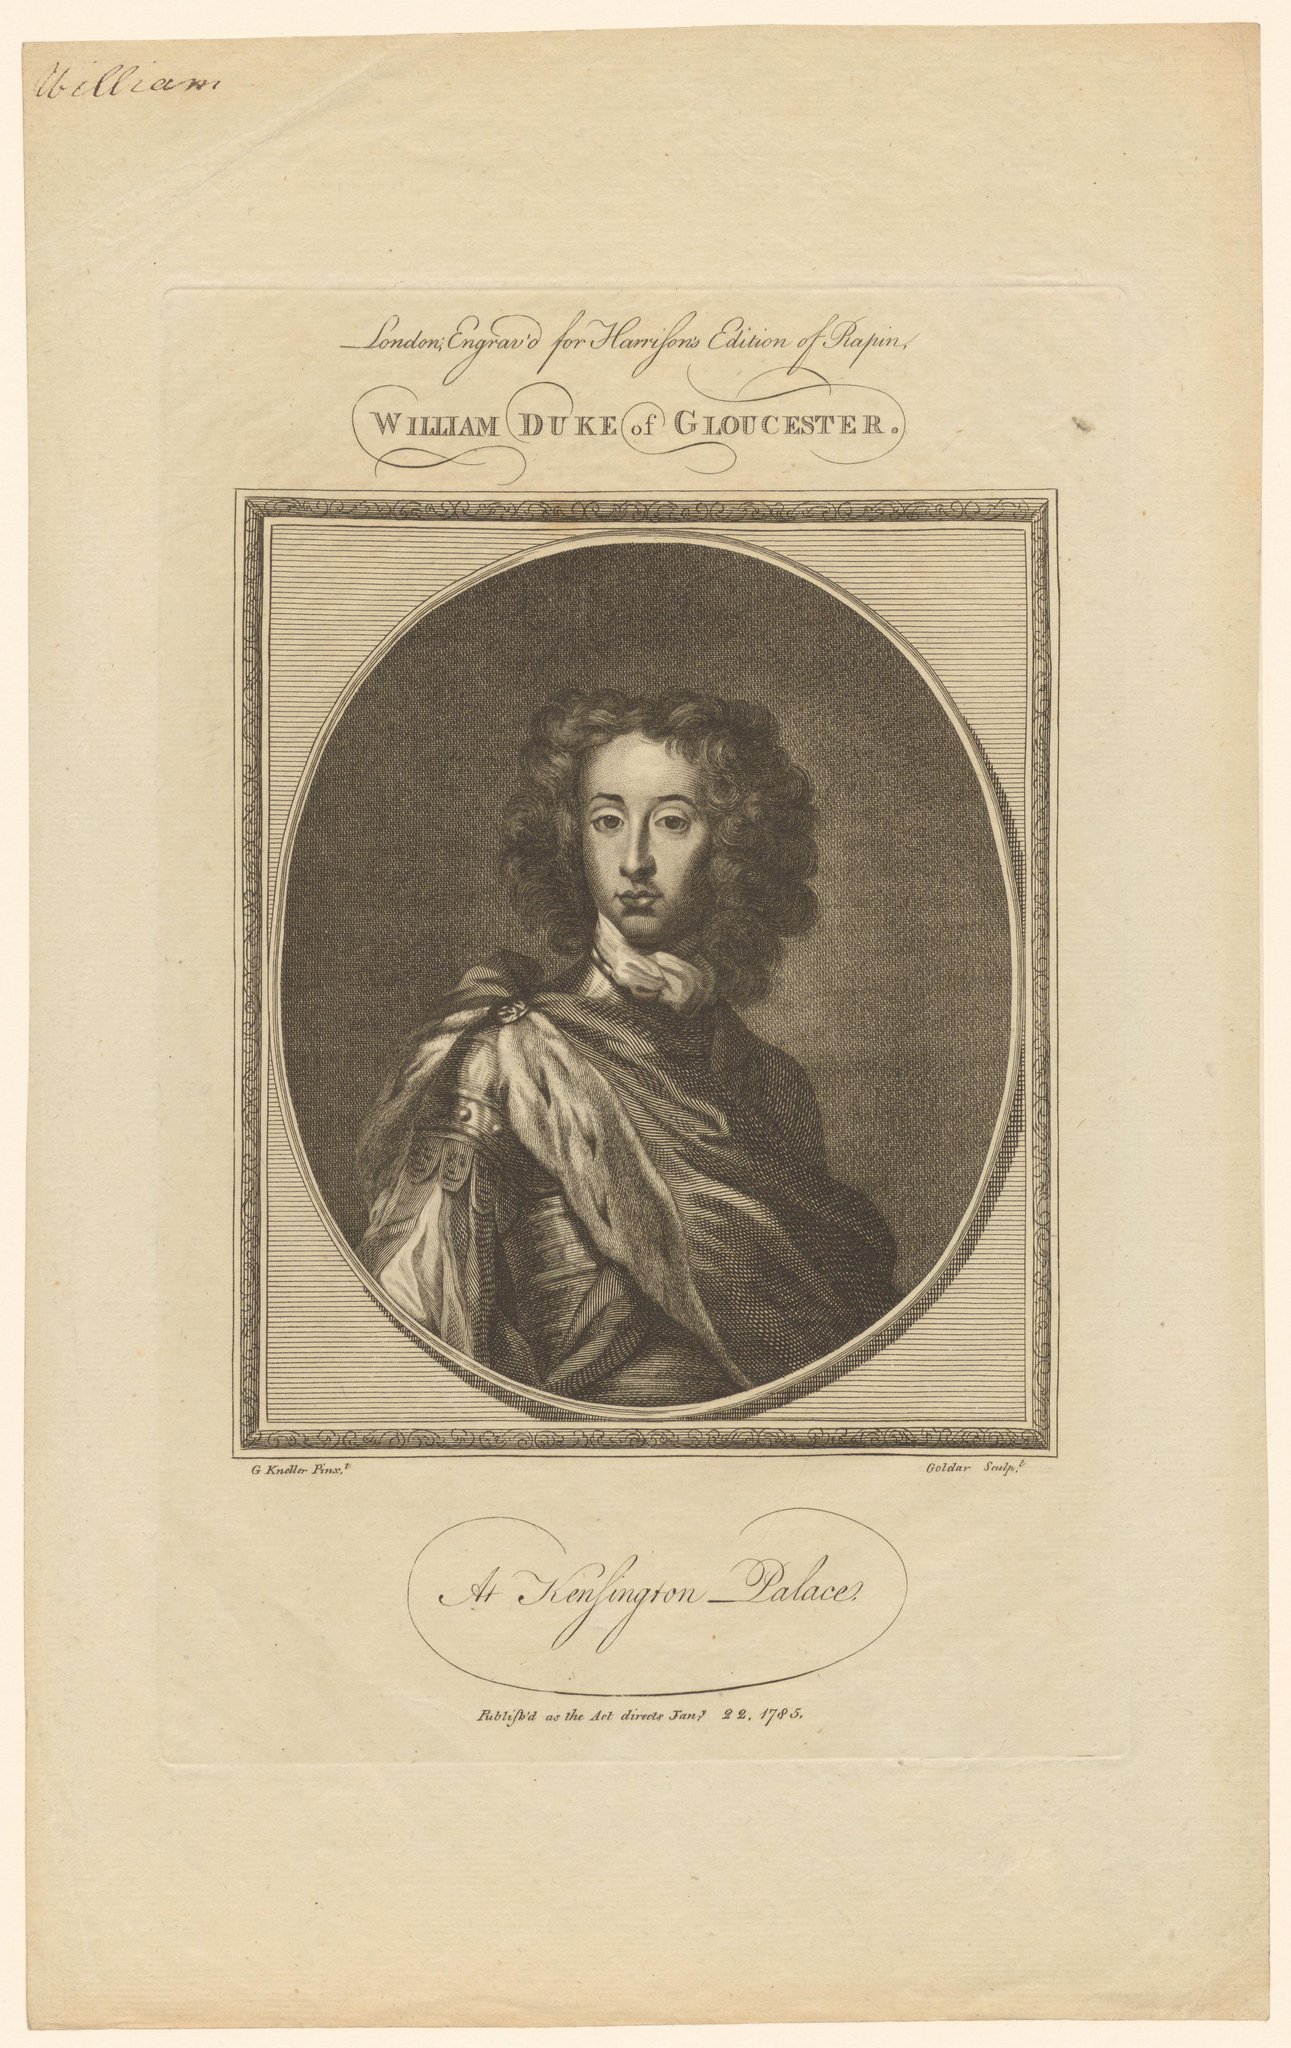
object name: book illustration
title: Portret van William, hertog van Gloucester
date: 1785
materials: paper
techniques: engraving, etching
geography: london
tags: historical persons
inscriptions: collector's mark: Lugt 2228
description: Prent is gebruikt in: Rapin, Paul de. History of England. [Vertaald uit het Frans door] Nicolas Tindal. Londen: John Harrison, 1785.